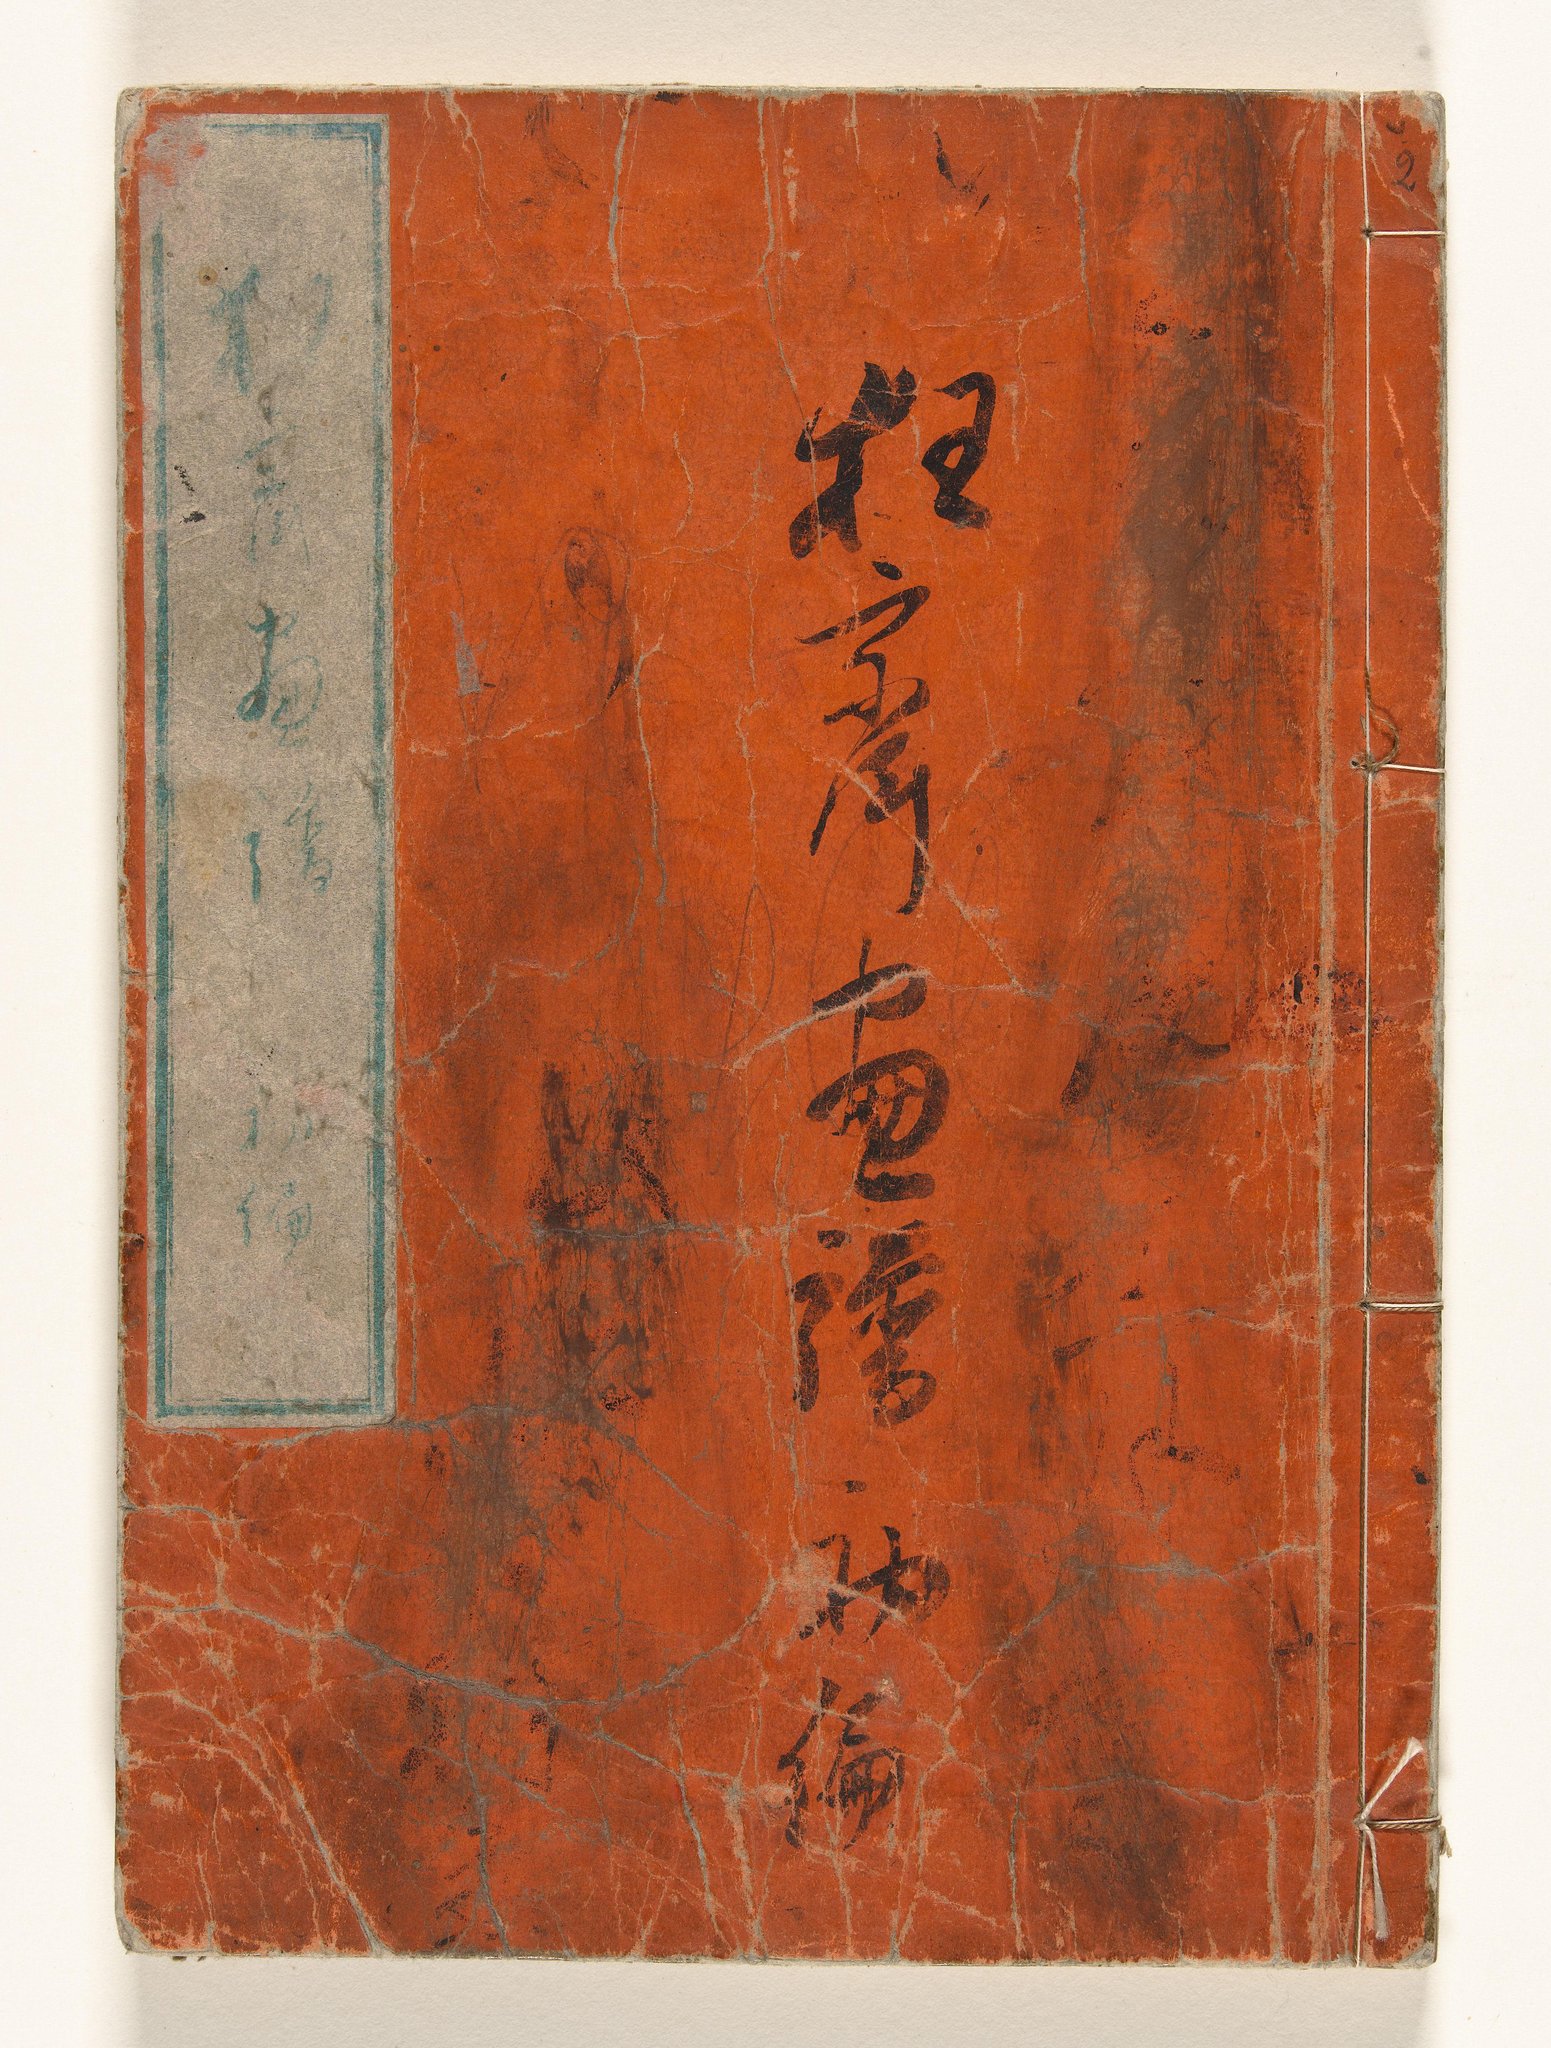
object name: book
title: Kyosai gafu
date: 1860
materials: paper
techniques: woodcut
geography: edo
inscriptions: date